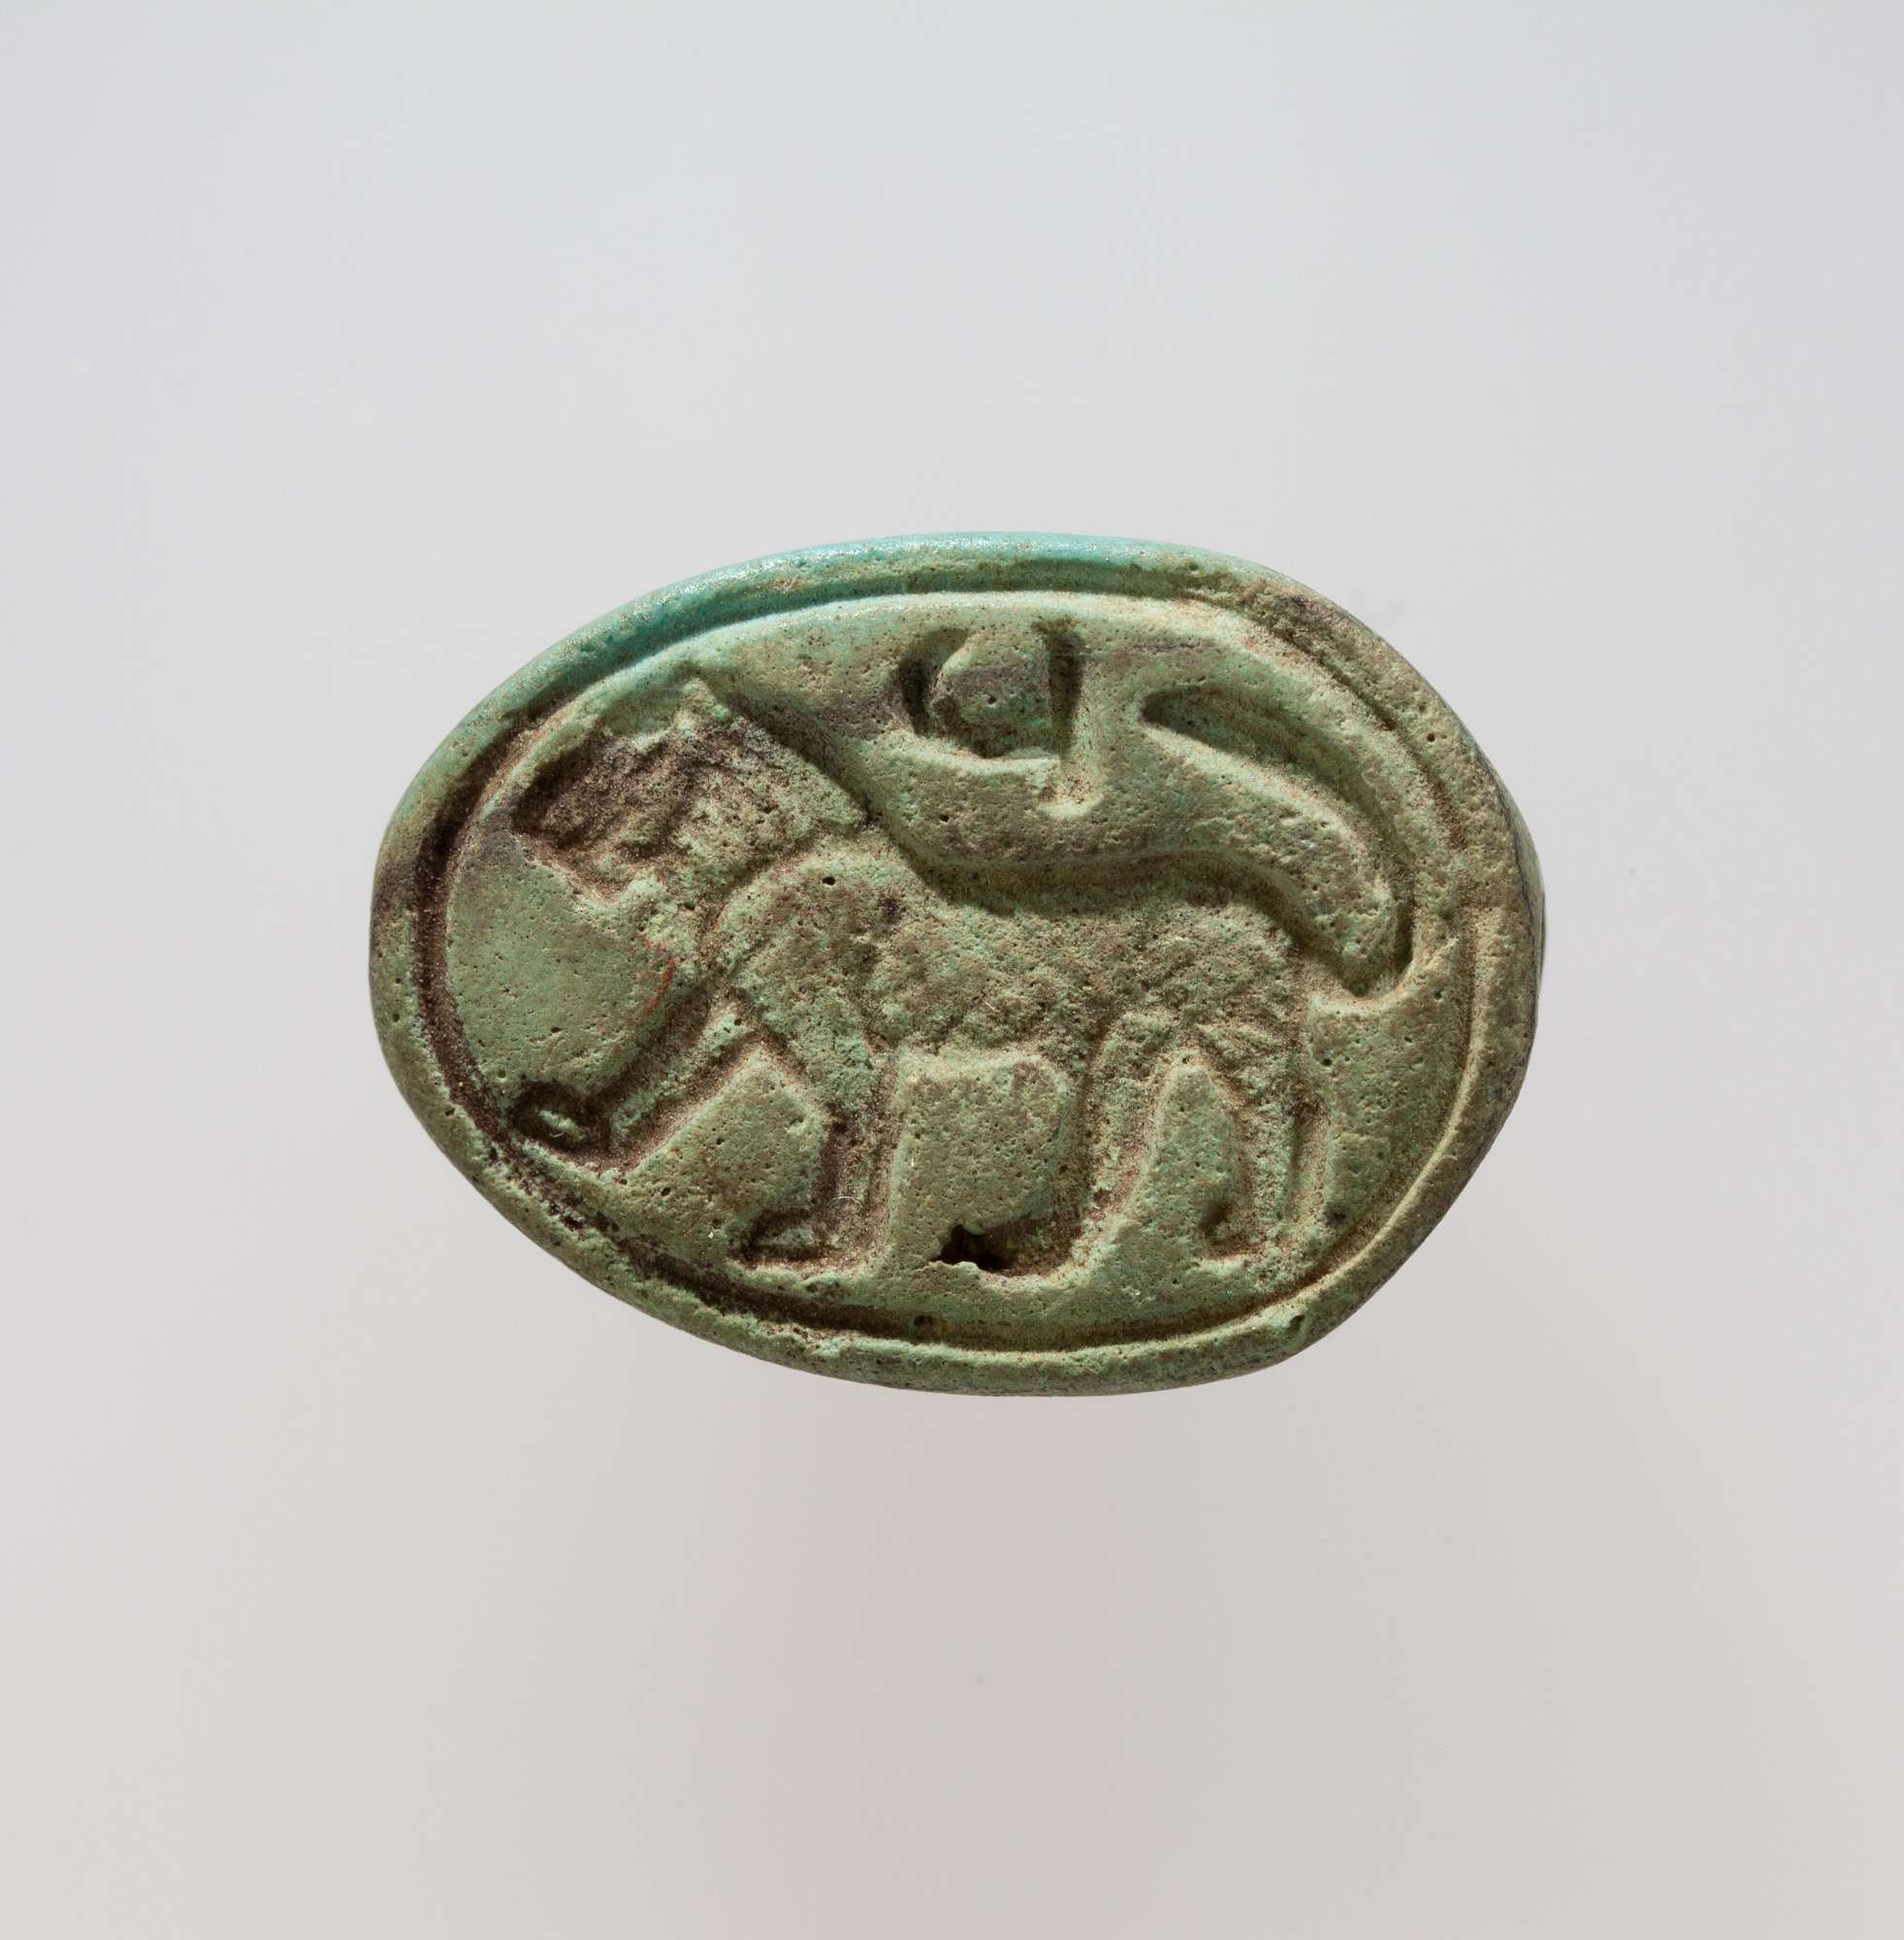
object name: scarab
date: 1479-1458 BCE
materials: faience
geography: egypt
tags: animals,scarabs